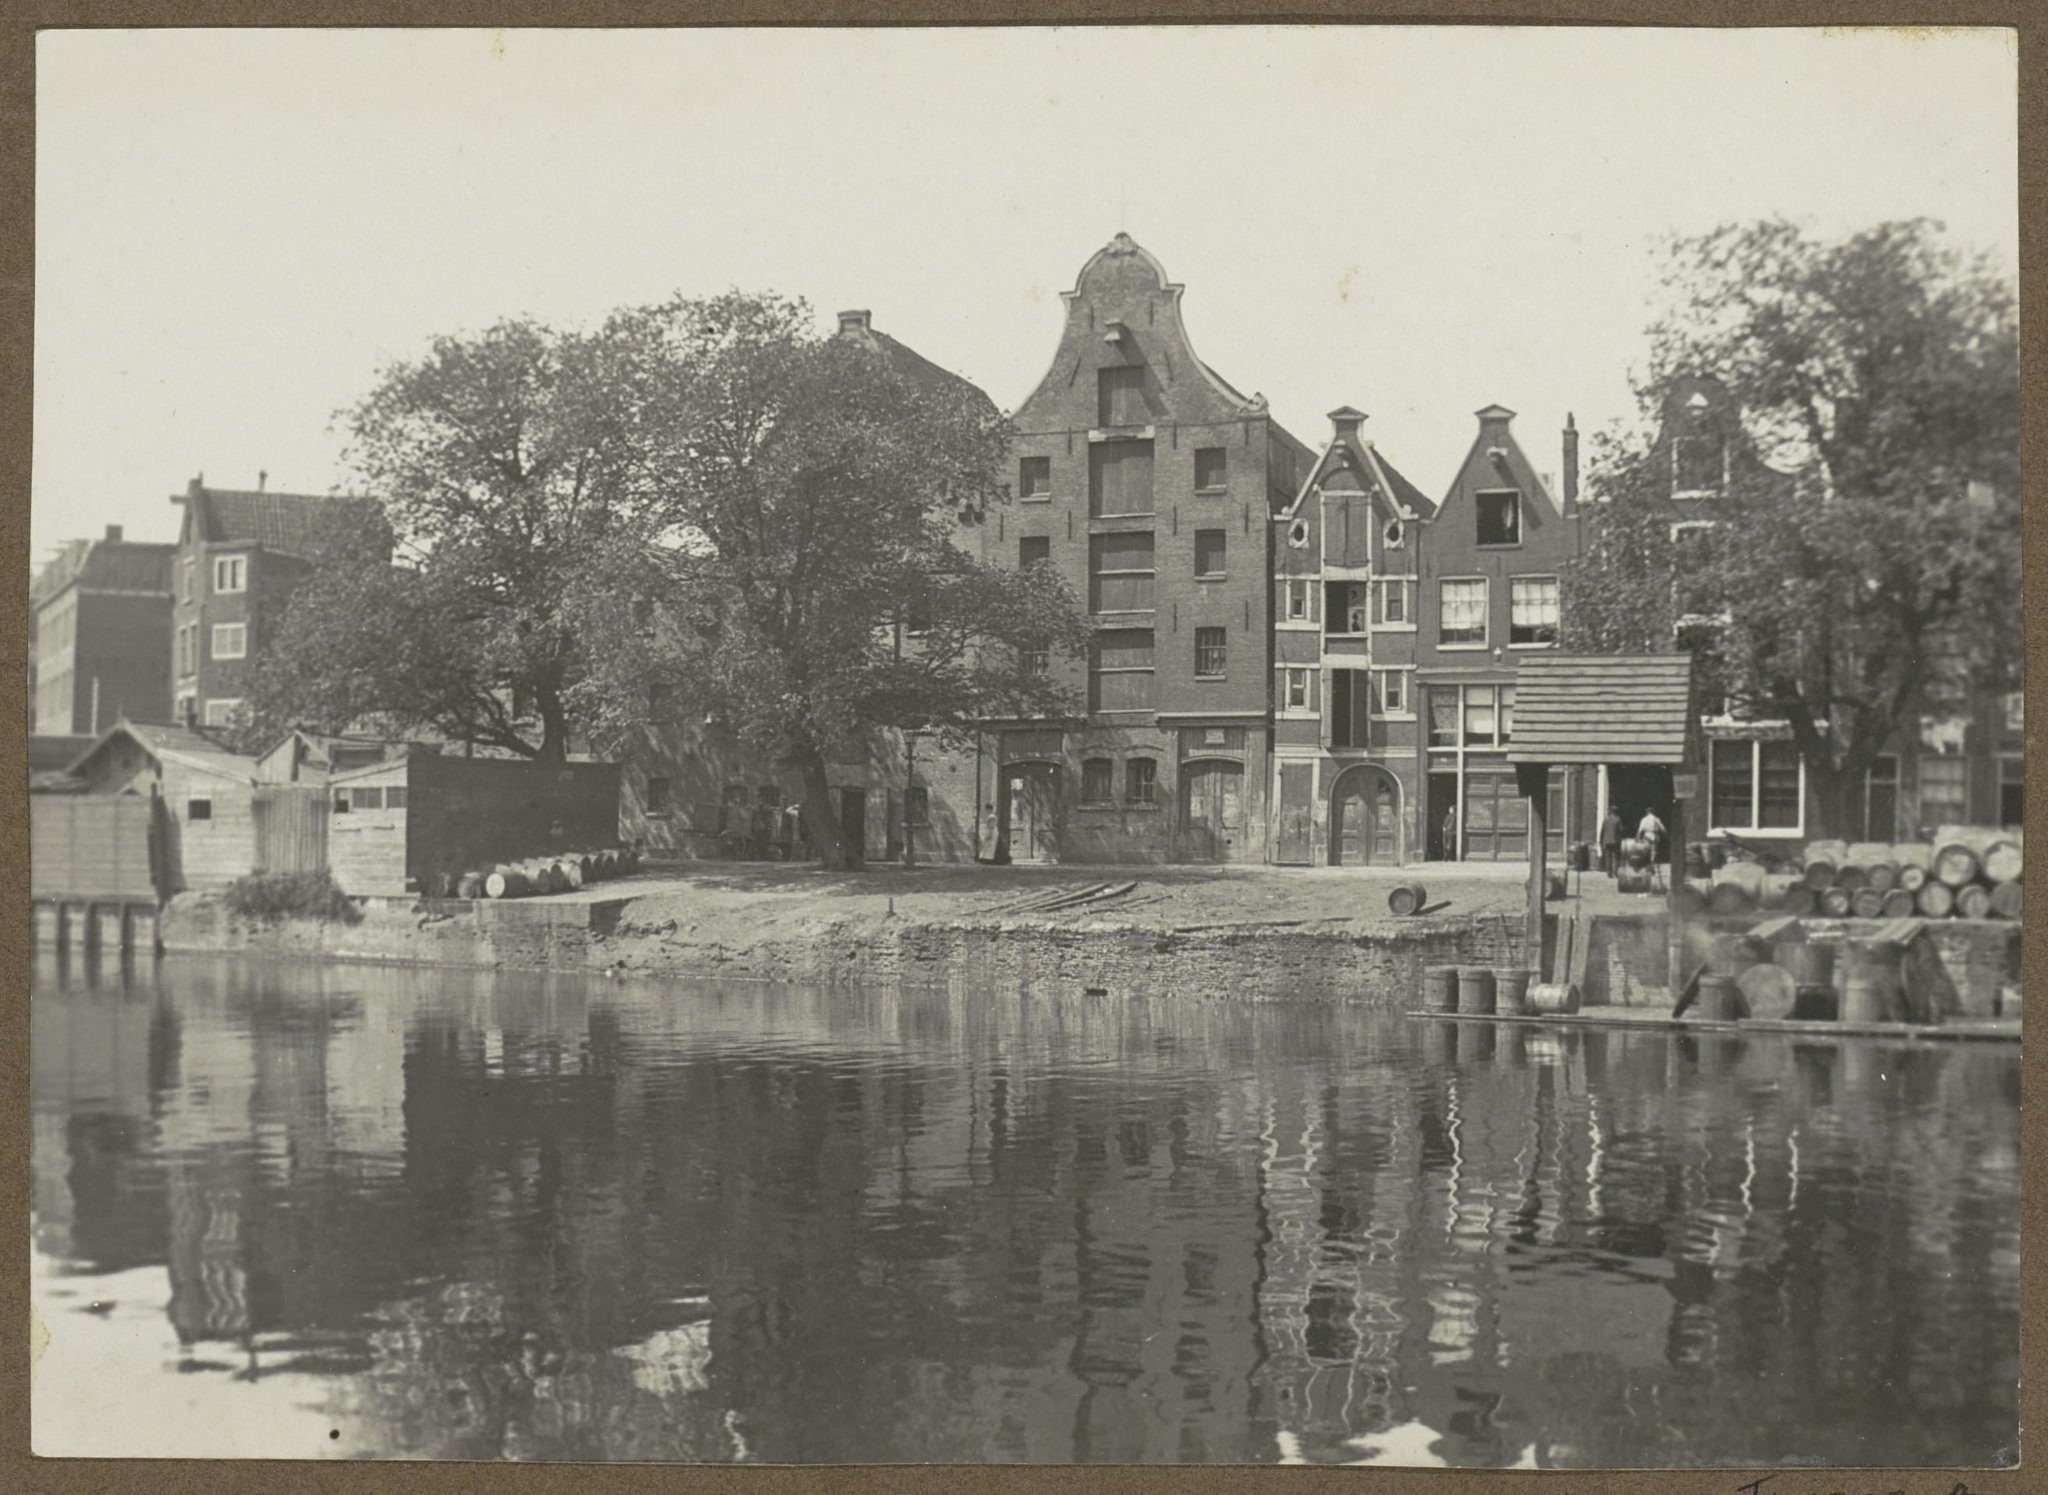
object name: photograph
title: Gezicht op de pakhuizen aan de Nieuwe Teertuinen in Amsterdam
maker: Anonymous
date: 1900-1915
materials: paper, photographic support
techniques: gelatin silver print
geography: amsterdam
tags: warehouse (~ harbour), quay (+ city(-scape) with figures, staffage)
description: Onderdeel van Album met foto's van Amsterdam en omgeving.